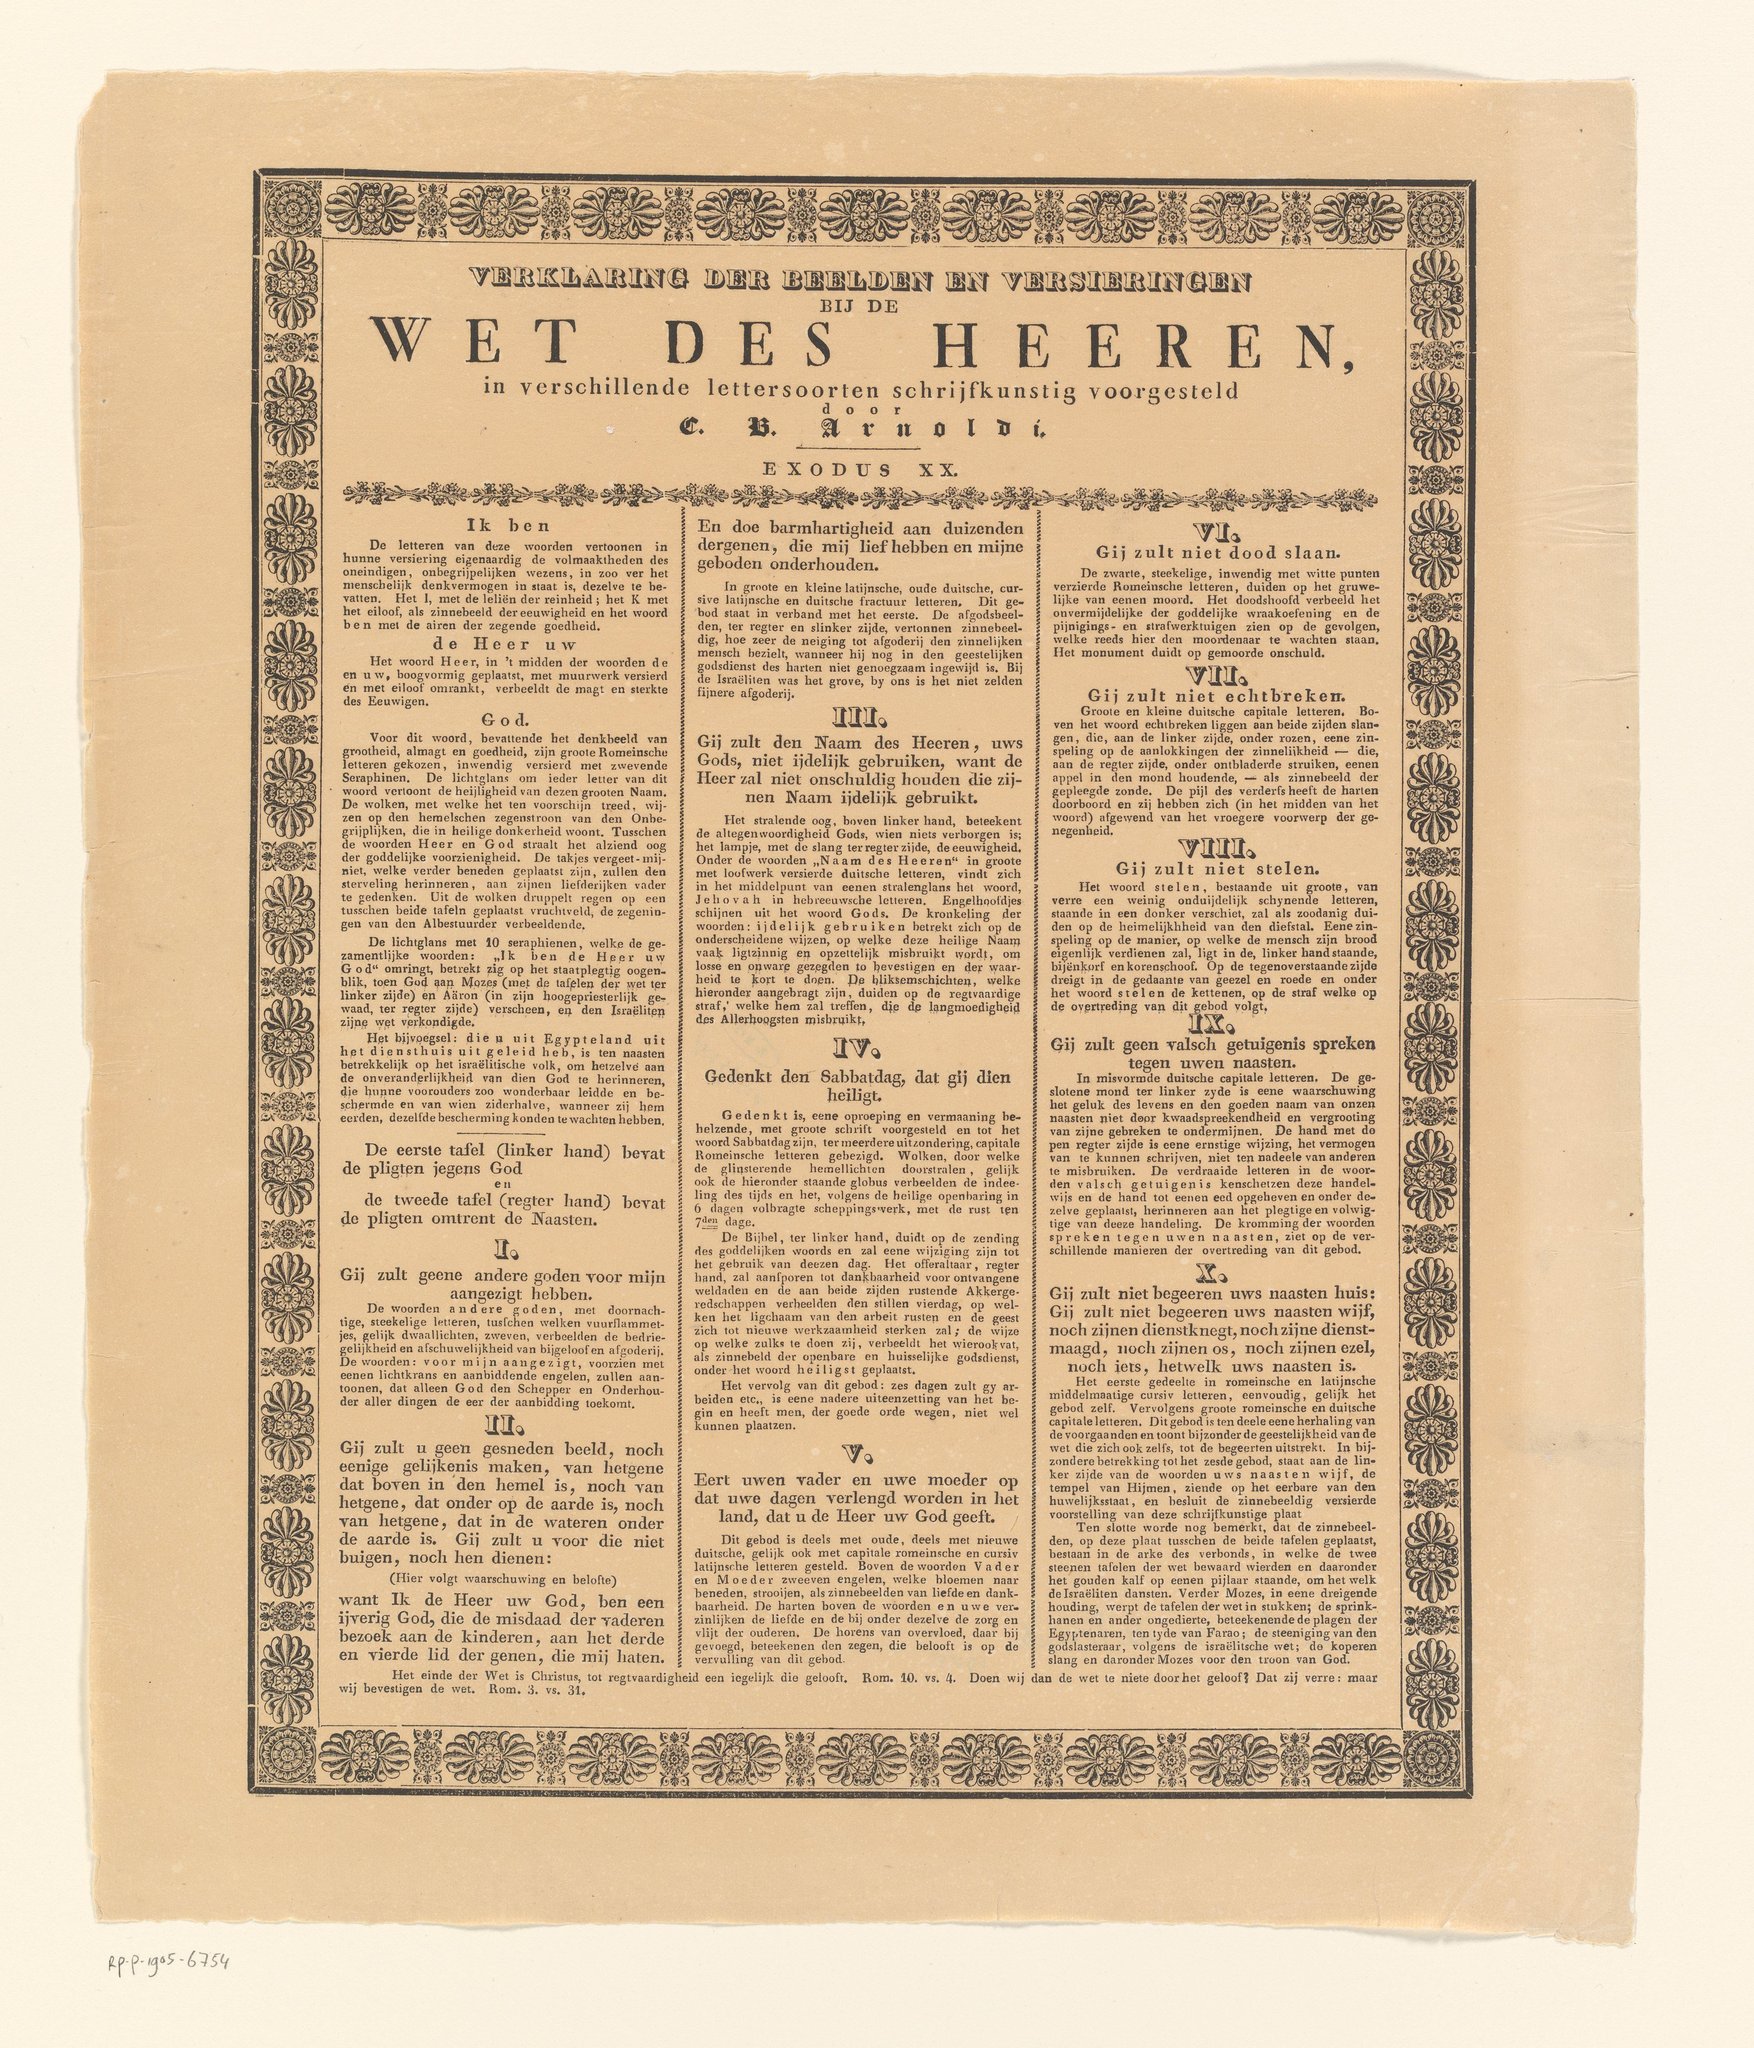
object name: print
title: Verklaring van voorstellingen op de prent 'Wet des Heeren'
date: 1820-1899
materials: paper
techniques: letterpress printing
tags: the book exodus: story of moses and aaron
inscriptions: collector's mark: Lugt 2228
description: Verklaring van de voorstellingen op het blad 'Wet des Heeren' (RP-P-1905-6755).